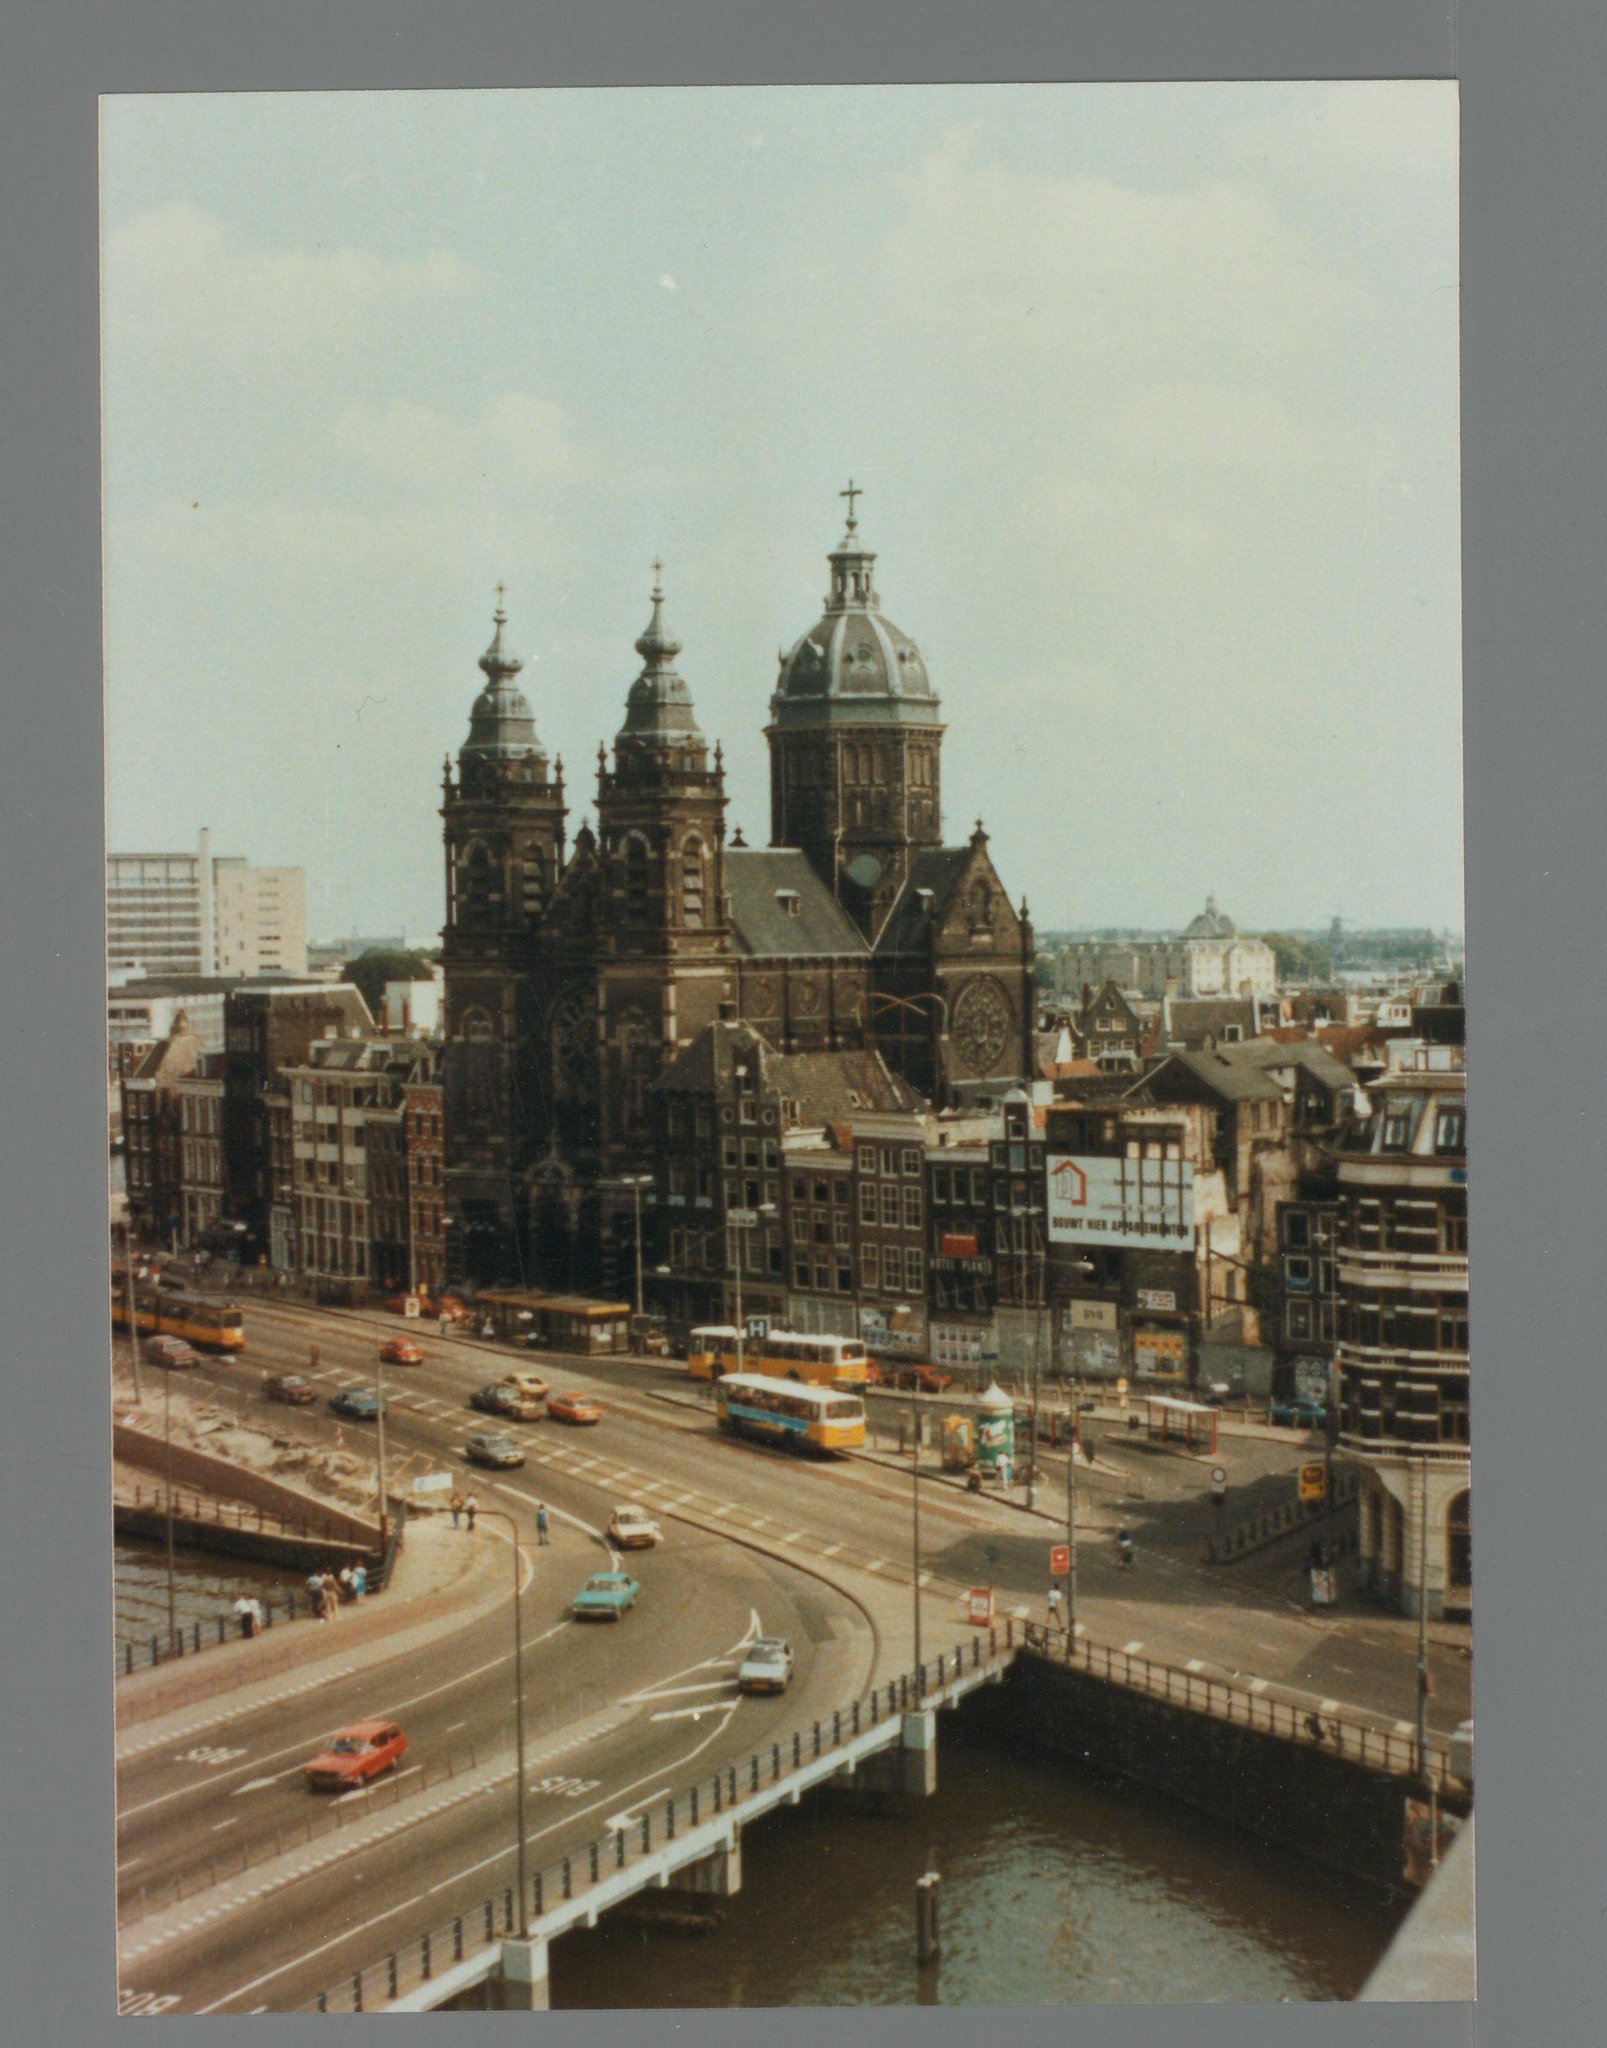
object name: photograph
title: Gezicht op de Sint-Nicolaaskerk te Amsterdam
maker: Anonymous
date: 1965-1970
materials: photographic support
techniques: chromogenic print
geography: amsterdam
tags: city-view, and landscape with man-made constructions, church (exterior)